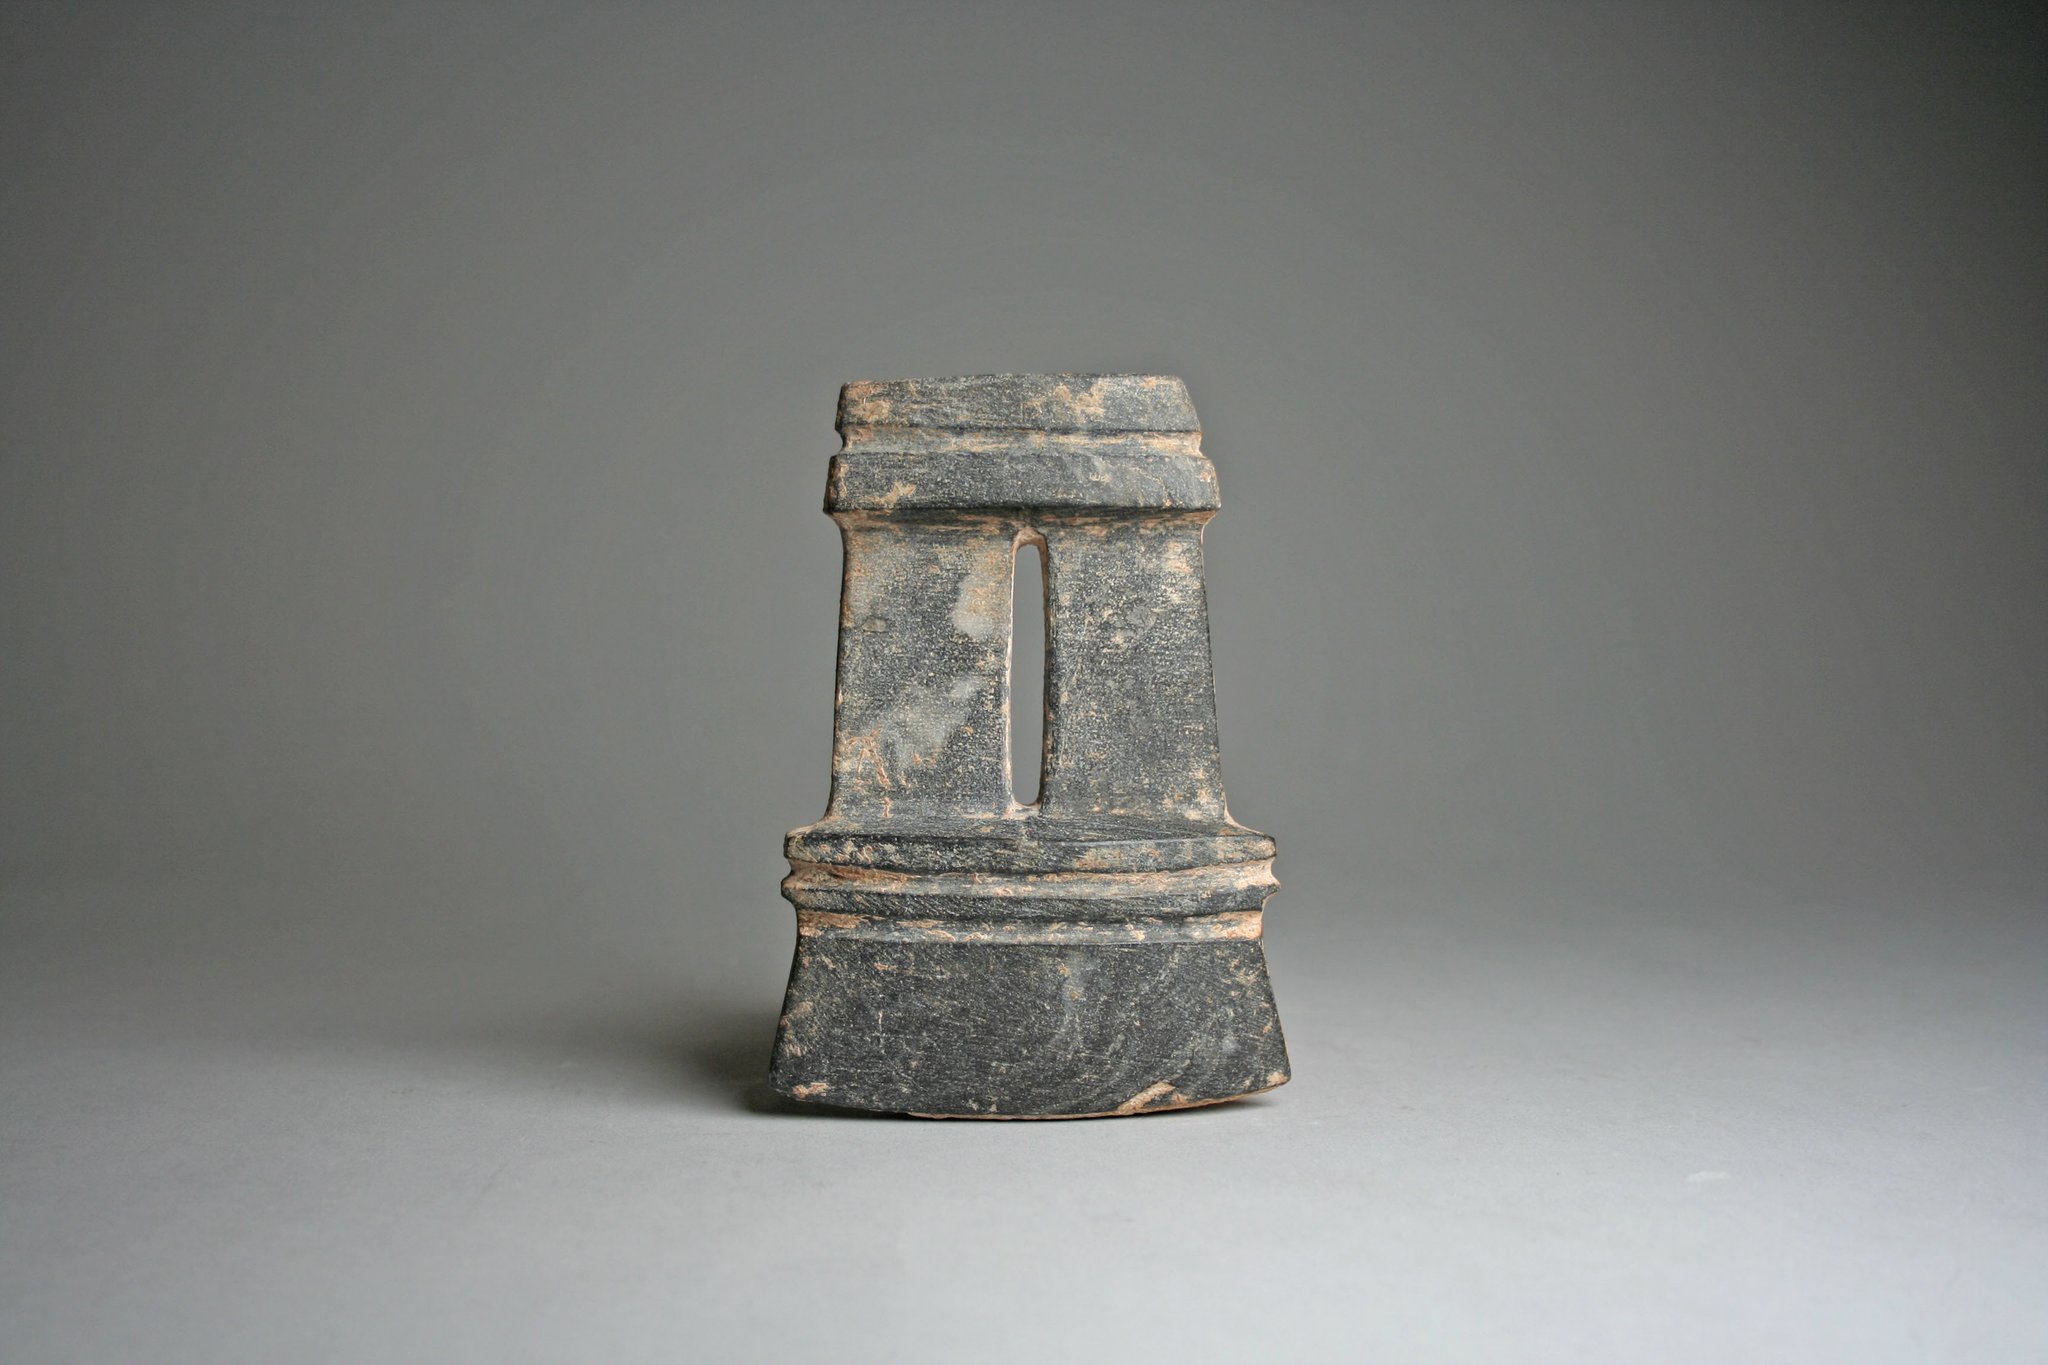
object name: architectural model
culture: mezcala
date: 1-800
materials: stone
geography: mexico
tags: temples